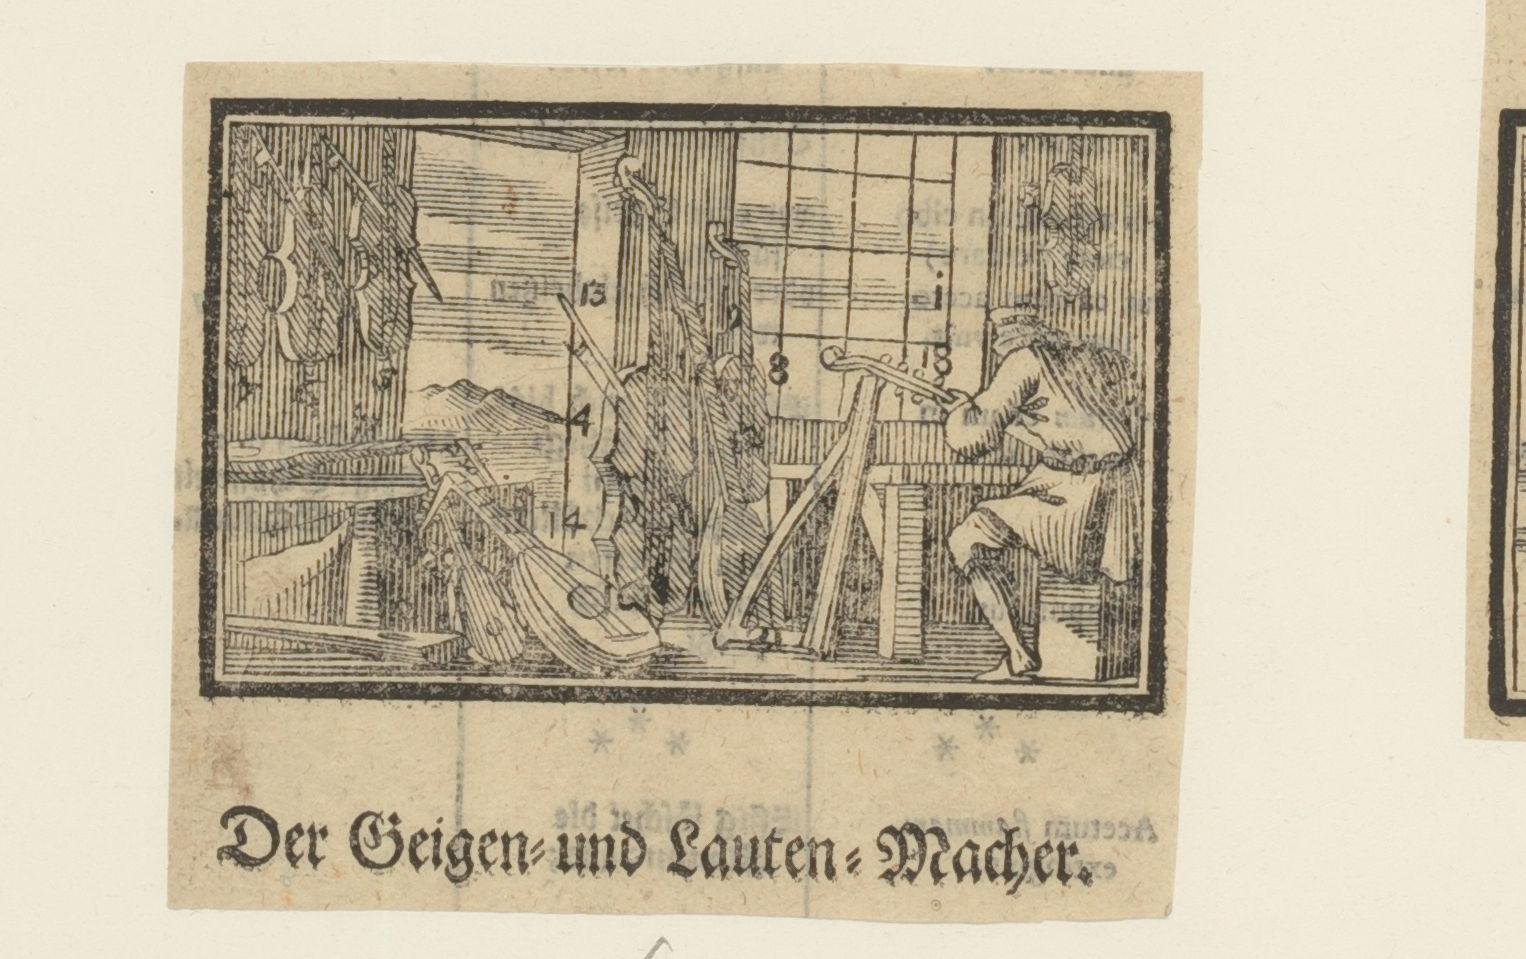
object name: print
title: Viool- en luitbouwer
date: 1719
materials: paper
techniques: letterpress printing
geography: nuremberg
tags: handicrafts, craftsman at work, violin, fiddle, lute, and special forms of lute, e.g.: theorbo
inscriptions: collector's mark: Lugt 1641, stamp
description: Prent uit: Comenius, Johannes Amosius. Orbis sensualium picti pars prima (...). Neurenberg: Martin Endter, 1719, dl. 2, p. 390. Prent eerder gebruikt in: Comenius, Johannes Amosius. Orbis Sensualium Picti denuo aucti Pars Secunda (...). Neurenberg: Martin Endter, 1730, dl. 2.